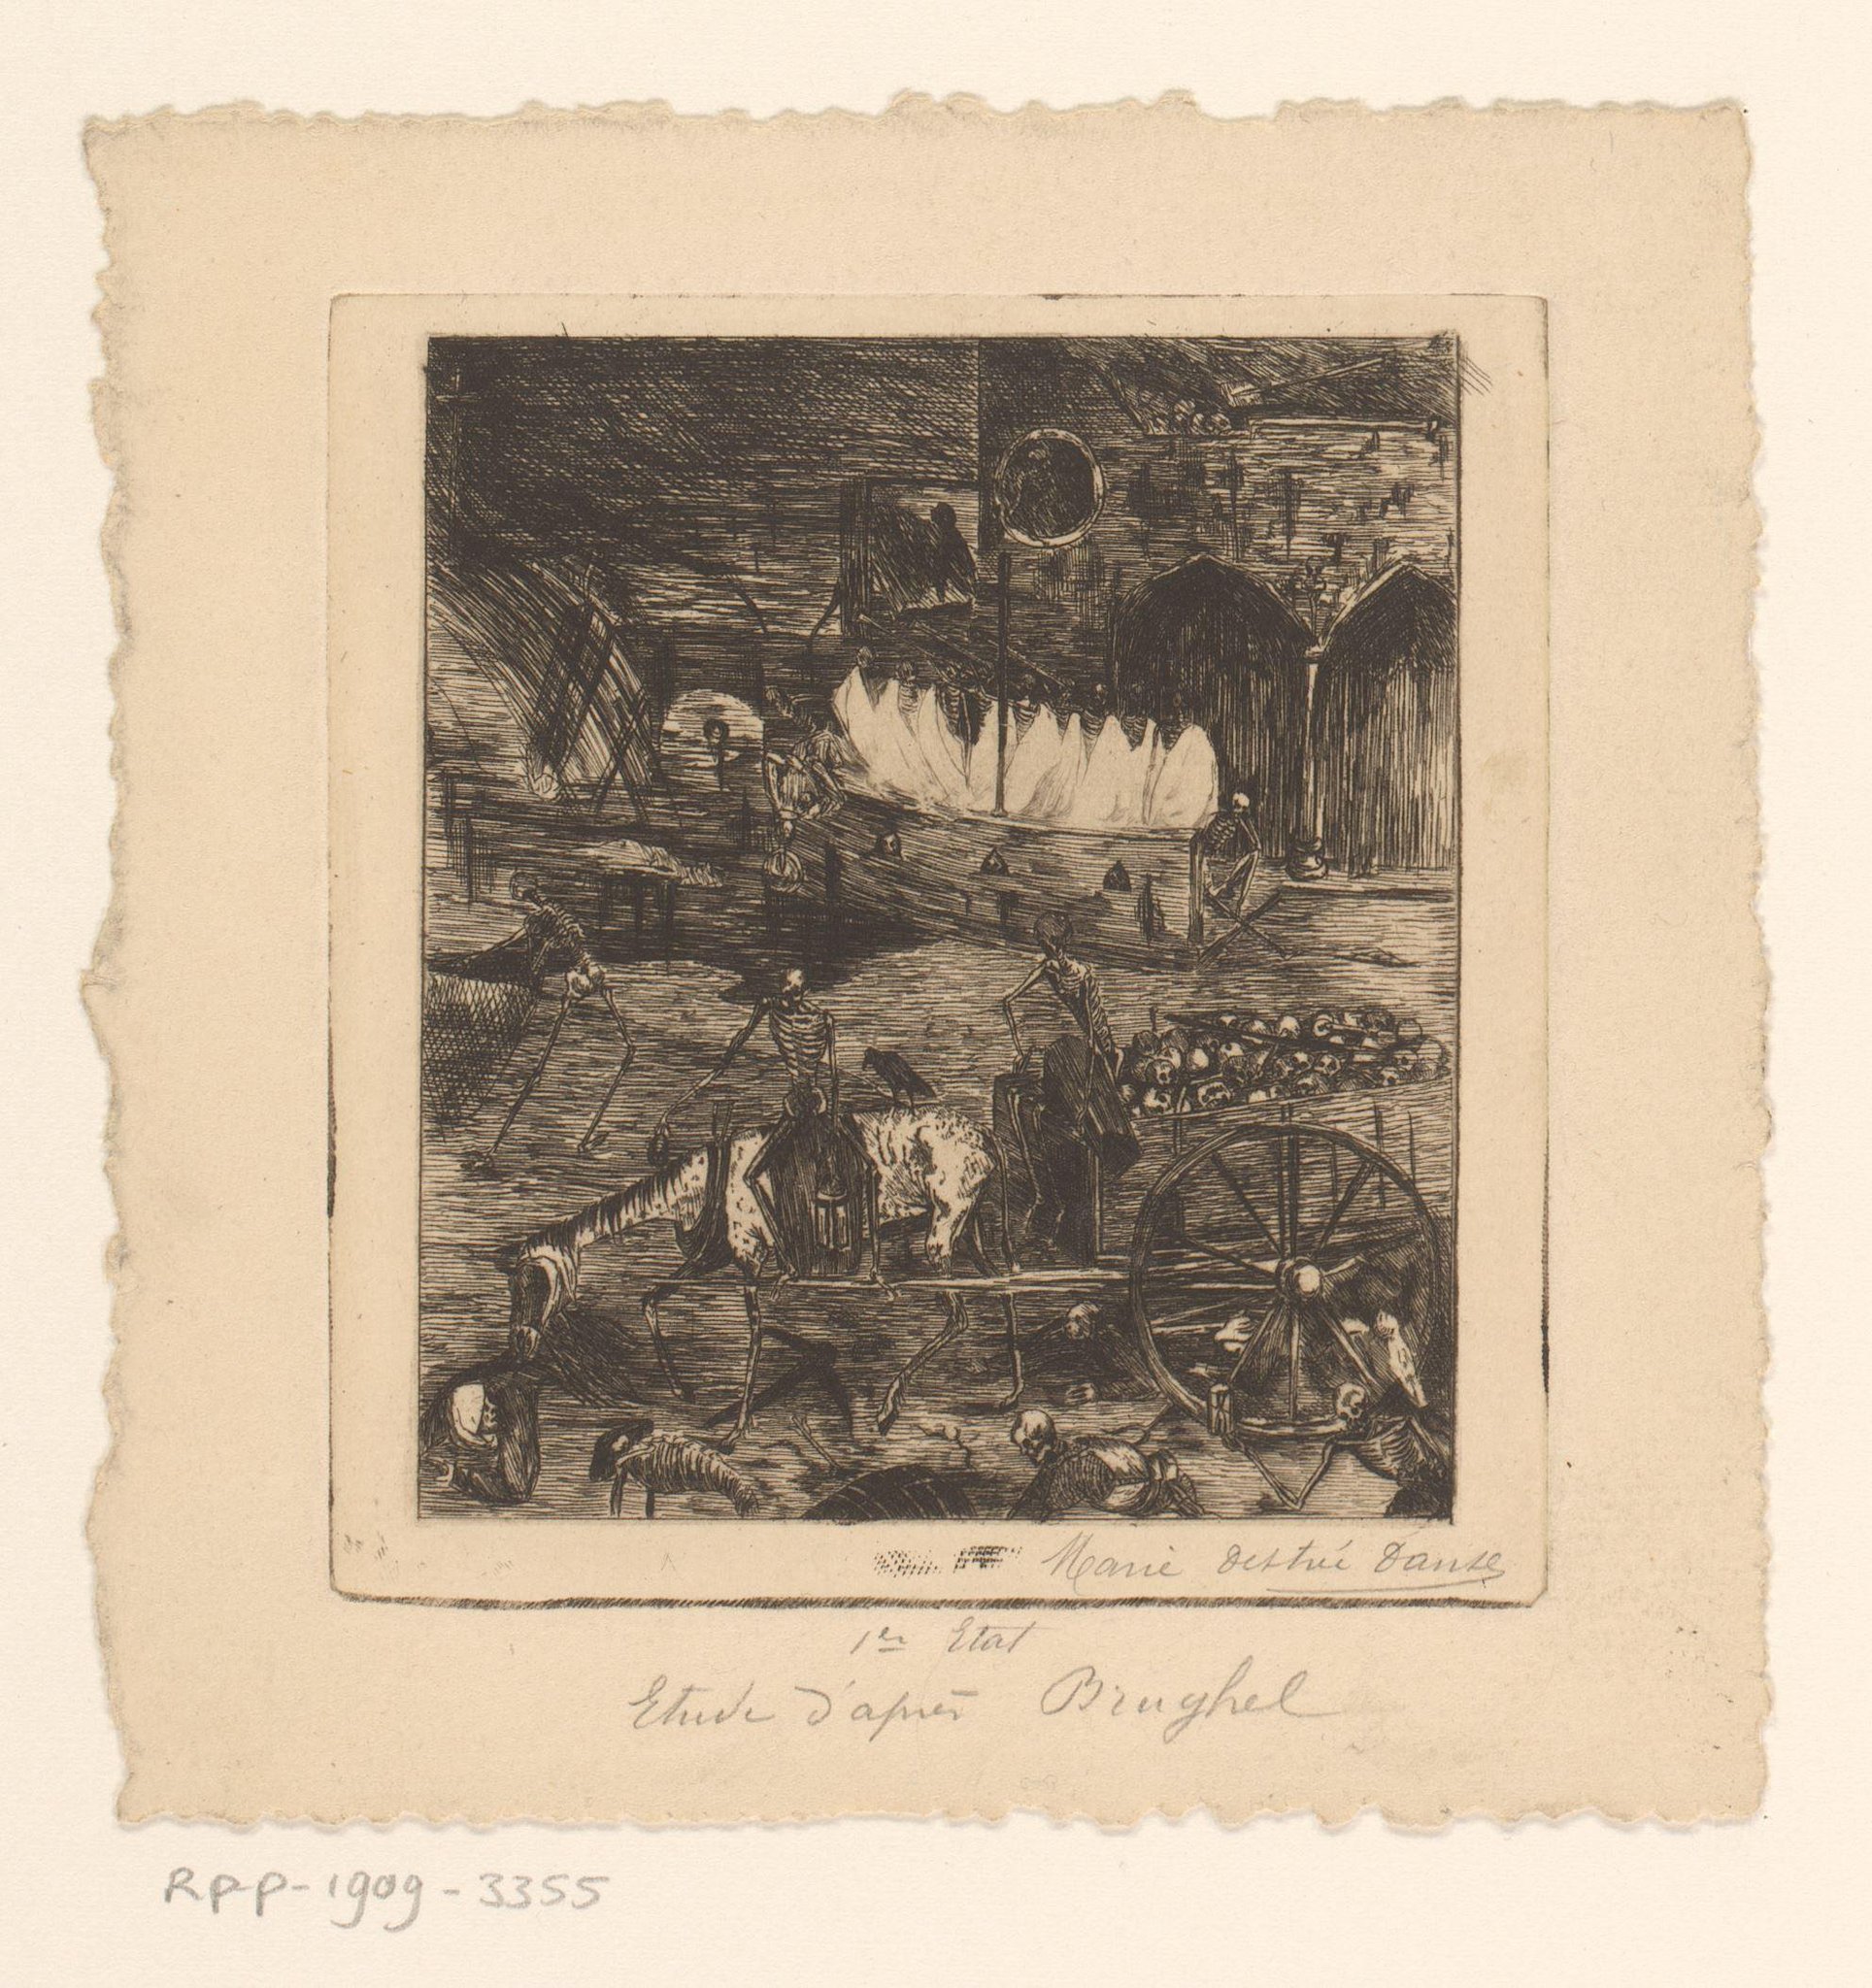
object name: print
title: Triomf van de dood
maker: marie danse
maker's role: print maker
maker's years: 1867-1942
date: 1877-1909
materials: paper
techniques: etching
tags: death as skeleton, 'trionfo della morte', 'triumphus mortis'; 'carro della morte' (ripa)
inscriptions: inscription: ‘1e Etat; Etude d'après Brughel’, collector's mark: Lugt 2228